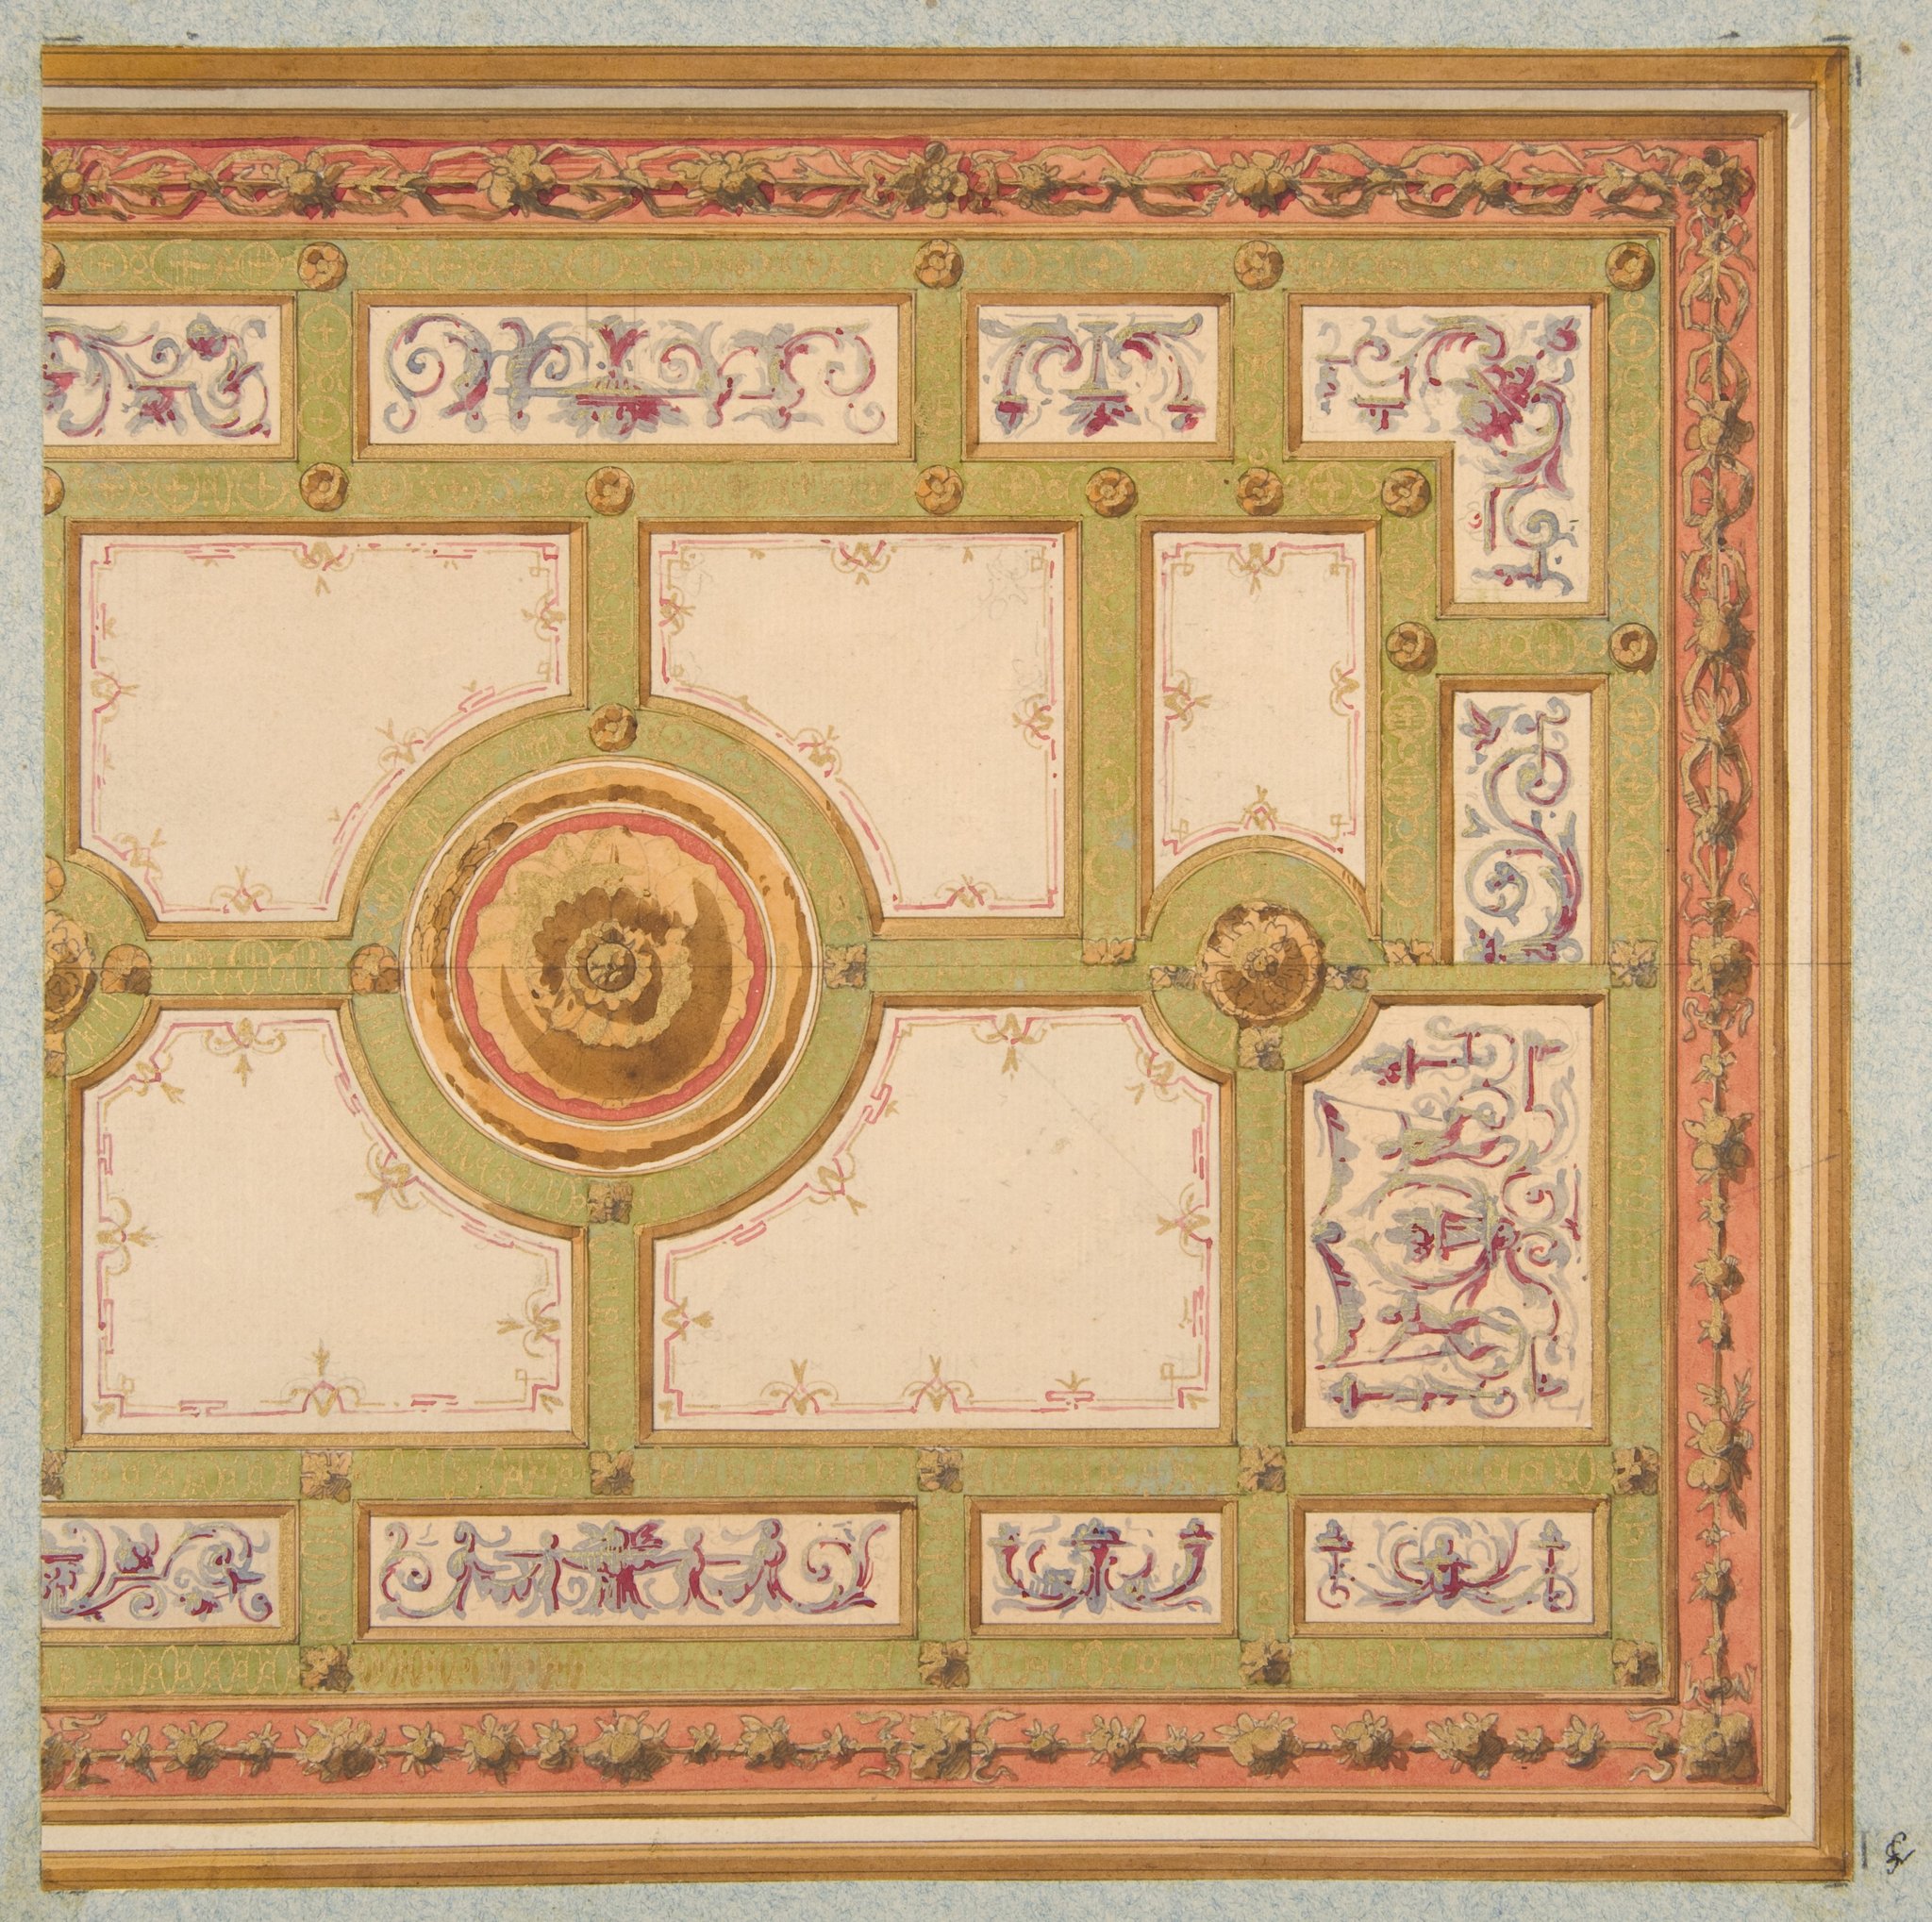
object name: drawing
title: Alternative designs for the painted decoration of a ceiling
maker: jules-edmond-charles lachaise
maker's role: artist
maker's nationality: french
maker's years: 1897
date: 1801-1900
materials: gold paint, ink, paper, watercolor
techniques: inlay, pen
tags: architecture